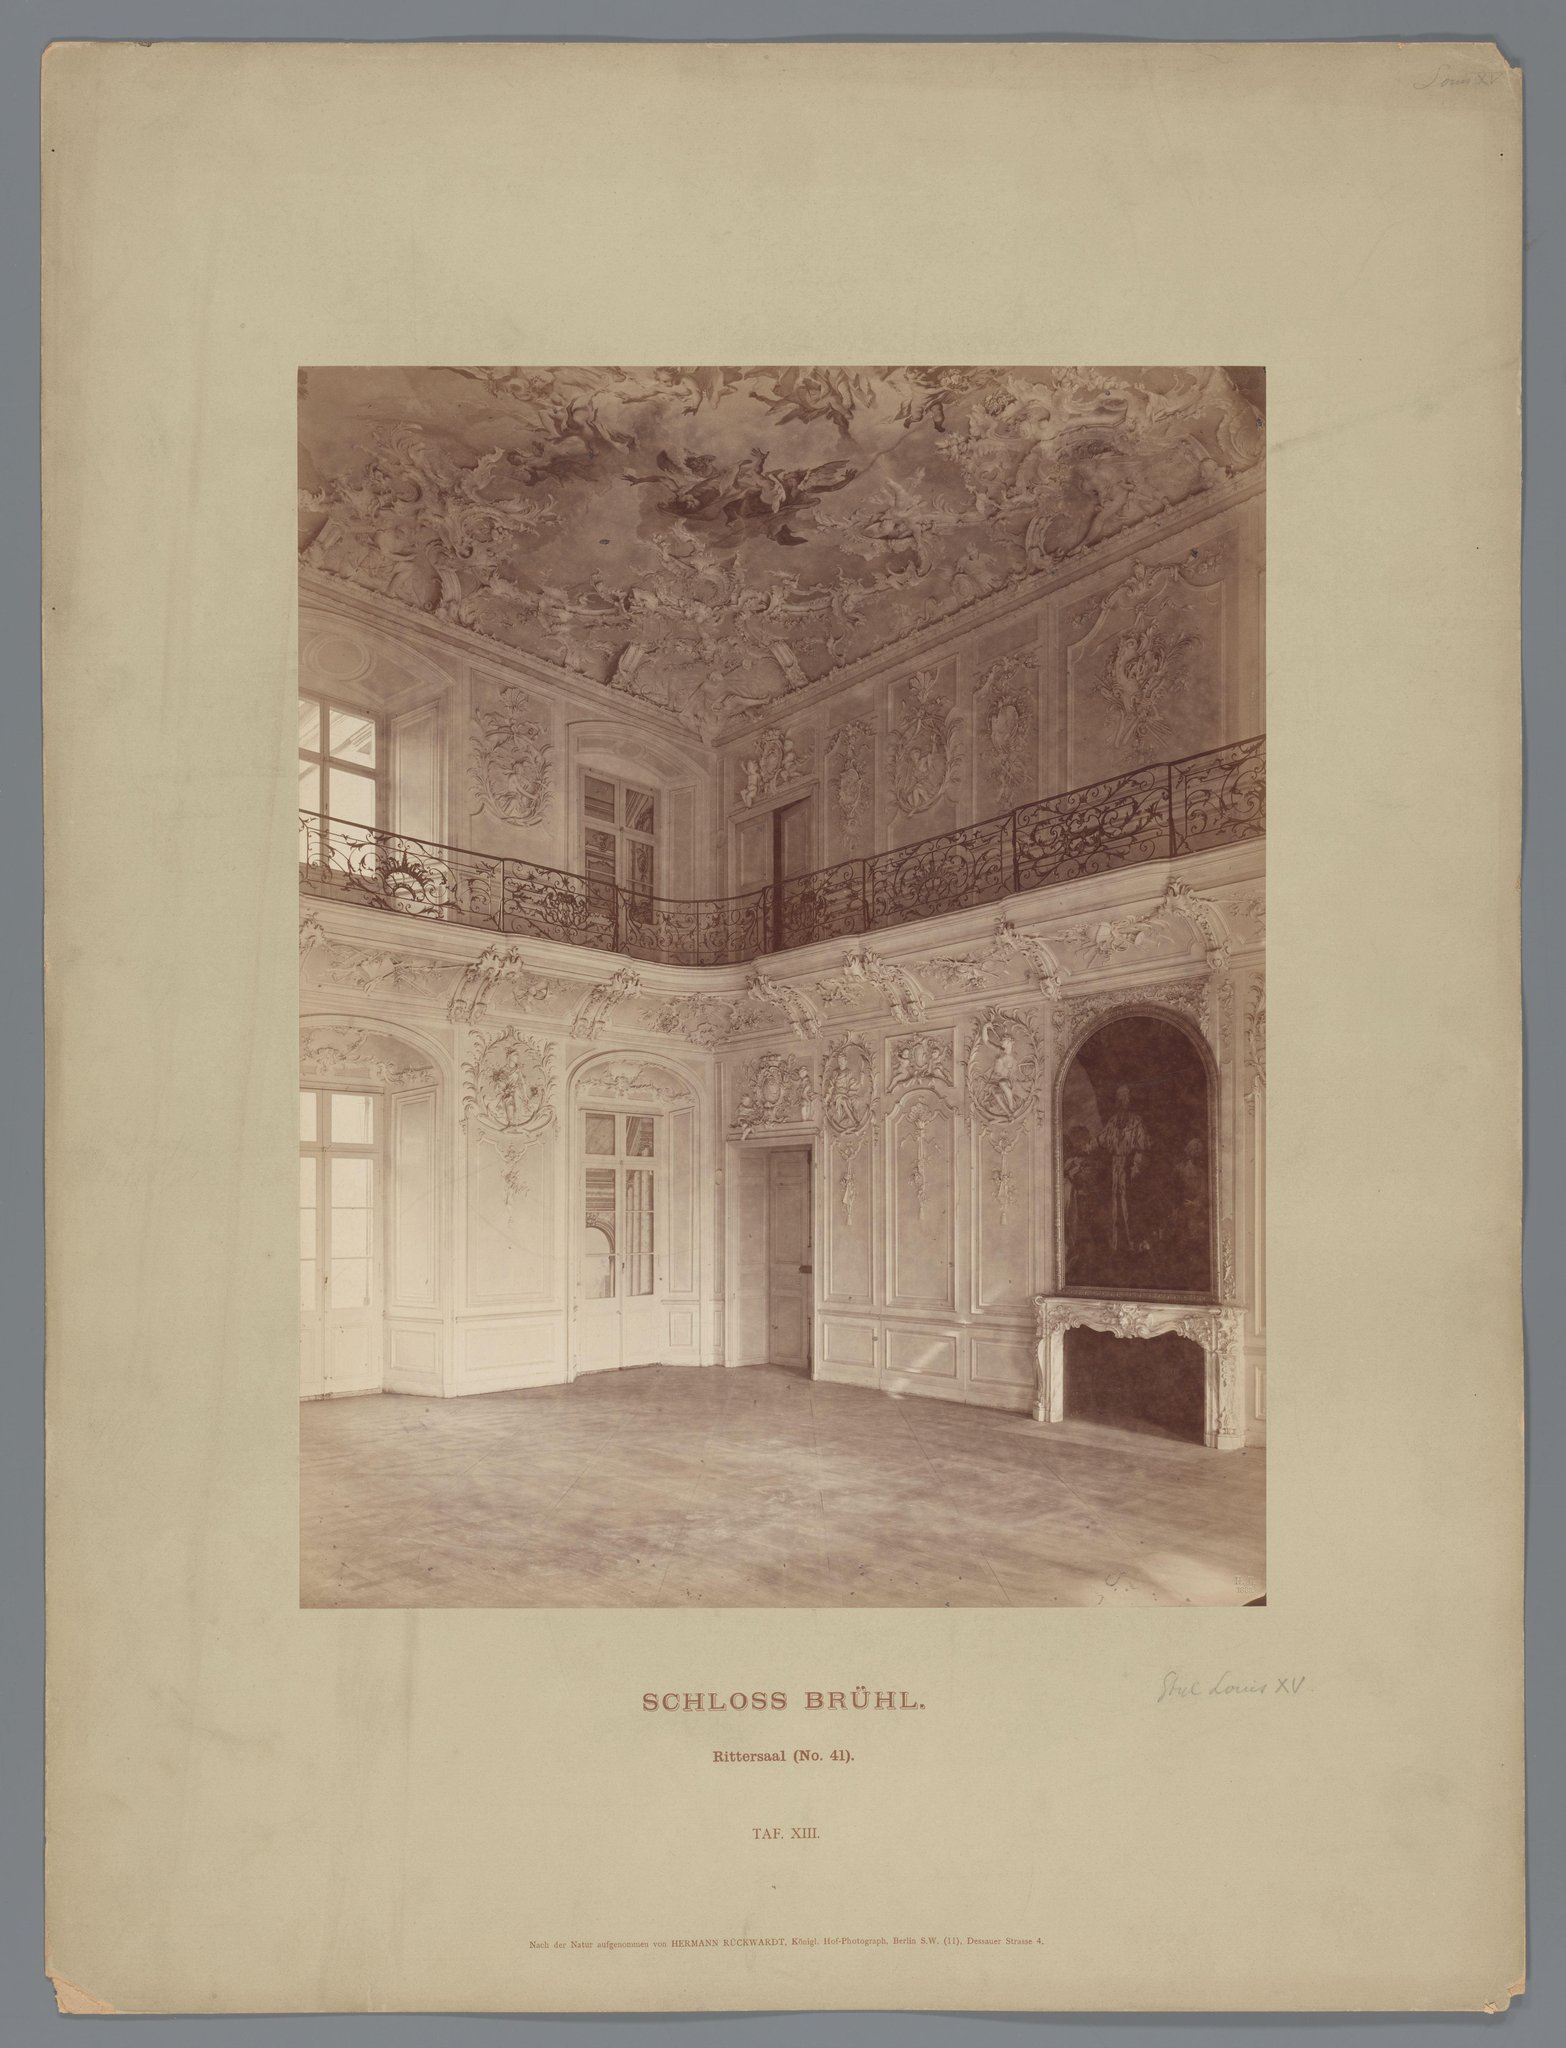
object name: photograph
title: Interieur van de ridderzaal van het Schloss Brühl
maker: hermann rückwardt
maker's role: fotograaf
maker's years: 1845-1919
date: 1883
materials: cardboard, paper, photographic support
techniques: albumen print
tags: palace, germany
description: Schloss Brühl. / Rittersaal (No. 41). Taf. XIII